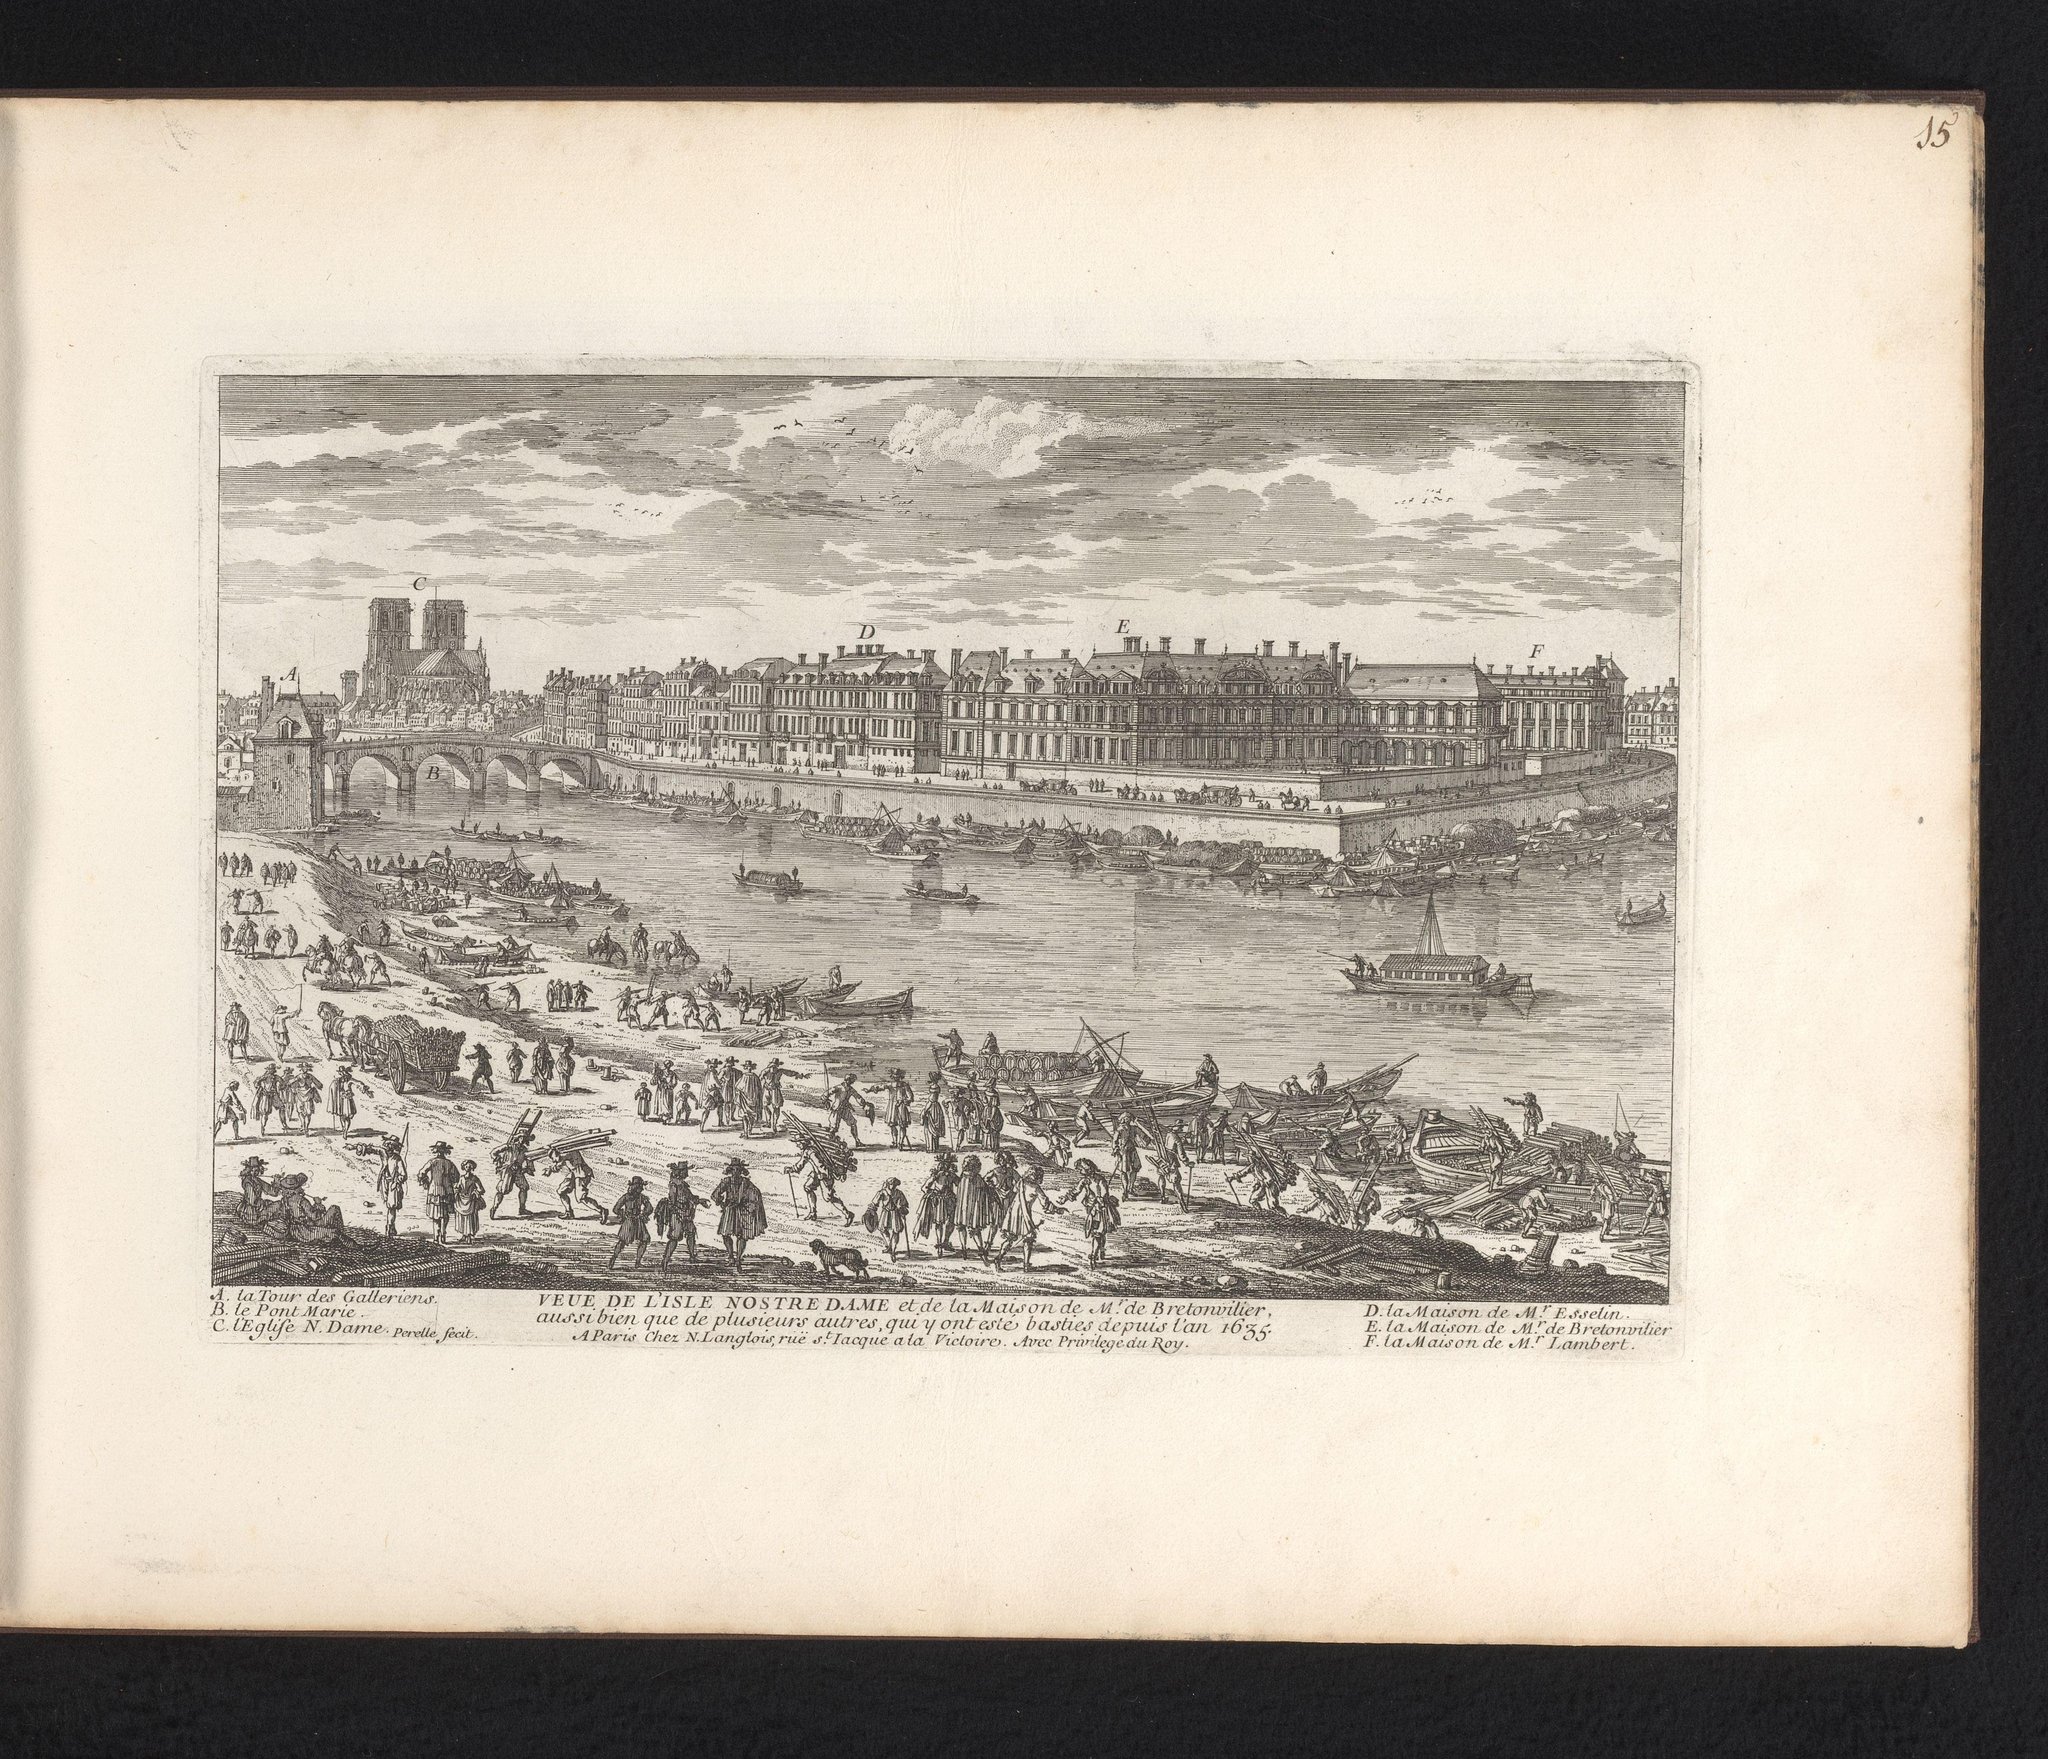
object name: print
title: Stadsgezicht met de Notre-Dame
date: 1620-1677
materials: paper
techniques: etching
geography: paris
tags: church (exterior), bridge in city across river, canal, etc.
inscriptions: collector's mark: Lugt 2228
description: Prenten met het signatuur 'Perelle' kunnen zowel door vader Gabriel als door zonen Nicolas en Adam gemaakt zijn. De uitgevers vader en zoon Nicolas Langlois worden allebei vermeld als N. Langlois op hetzelfde adres.